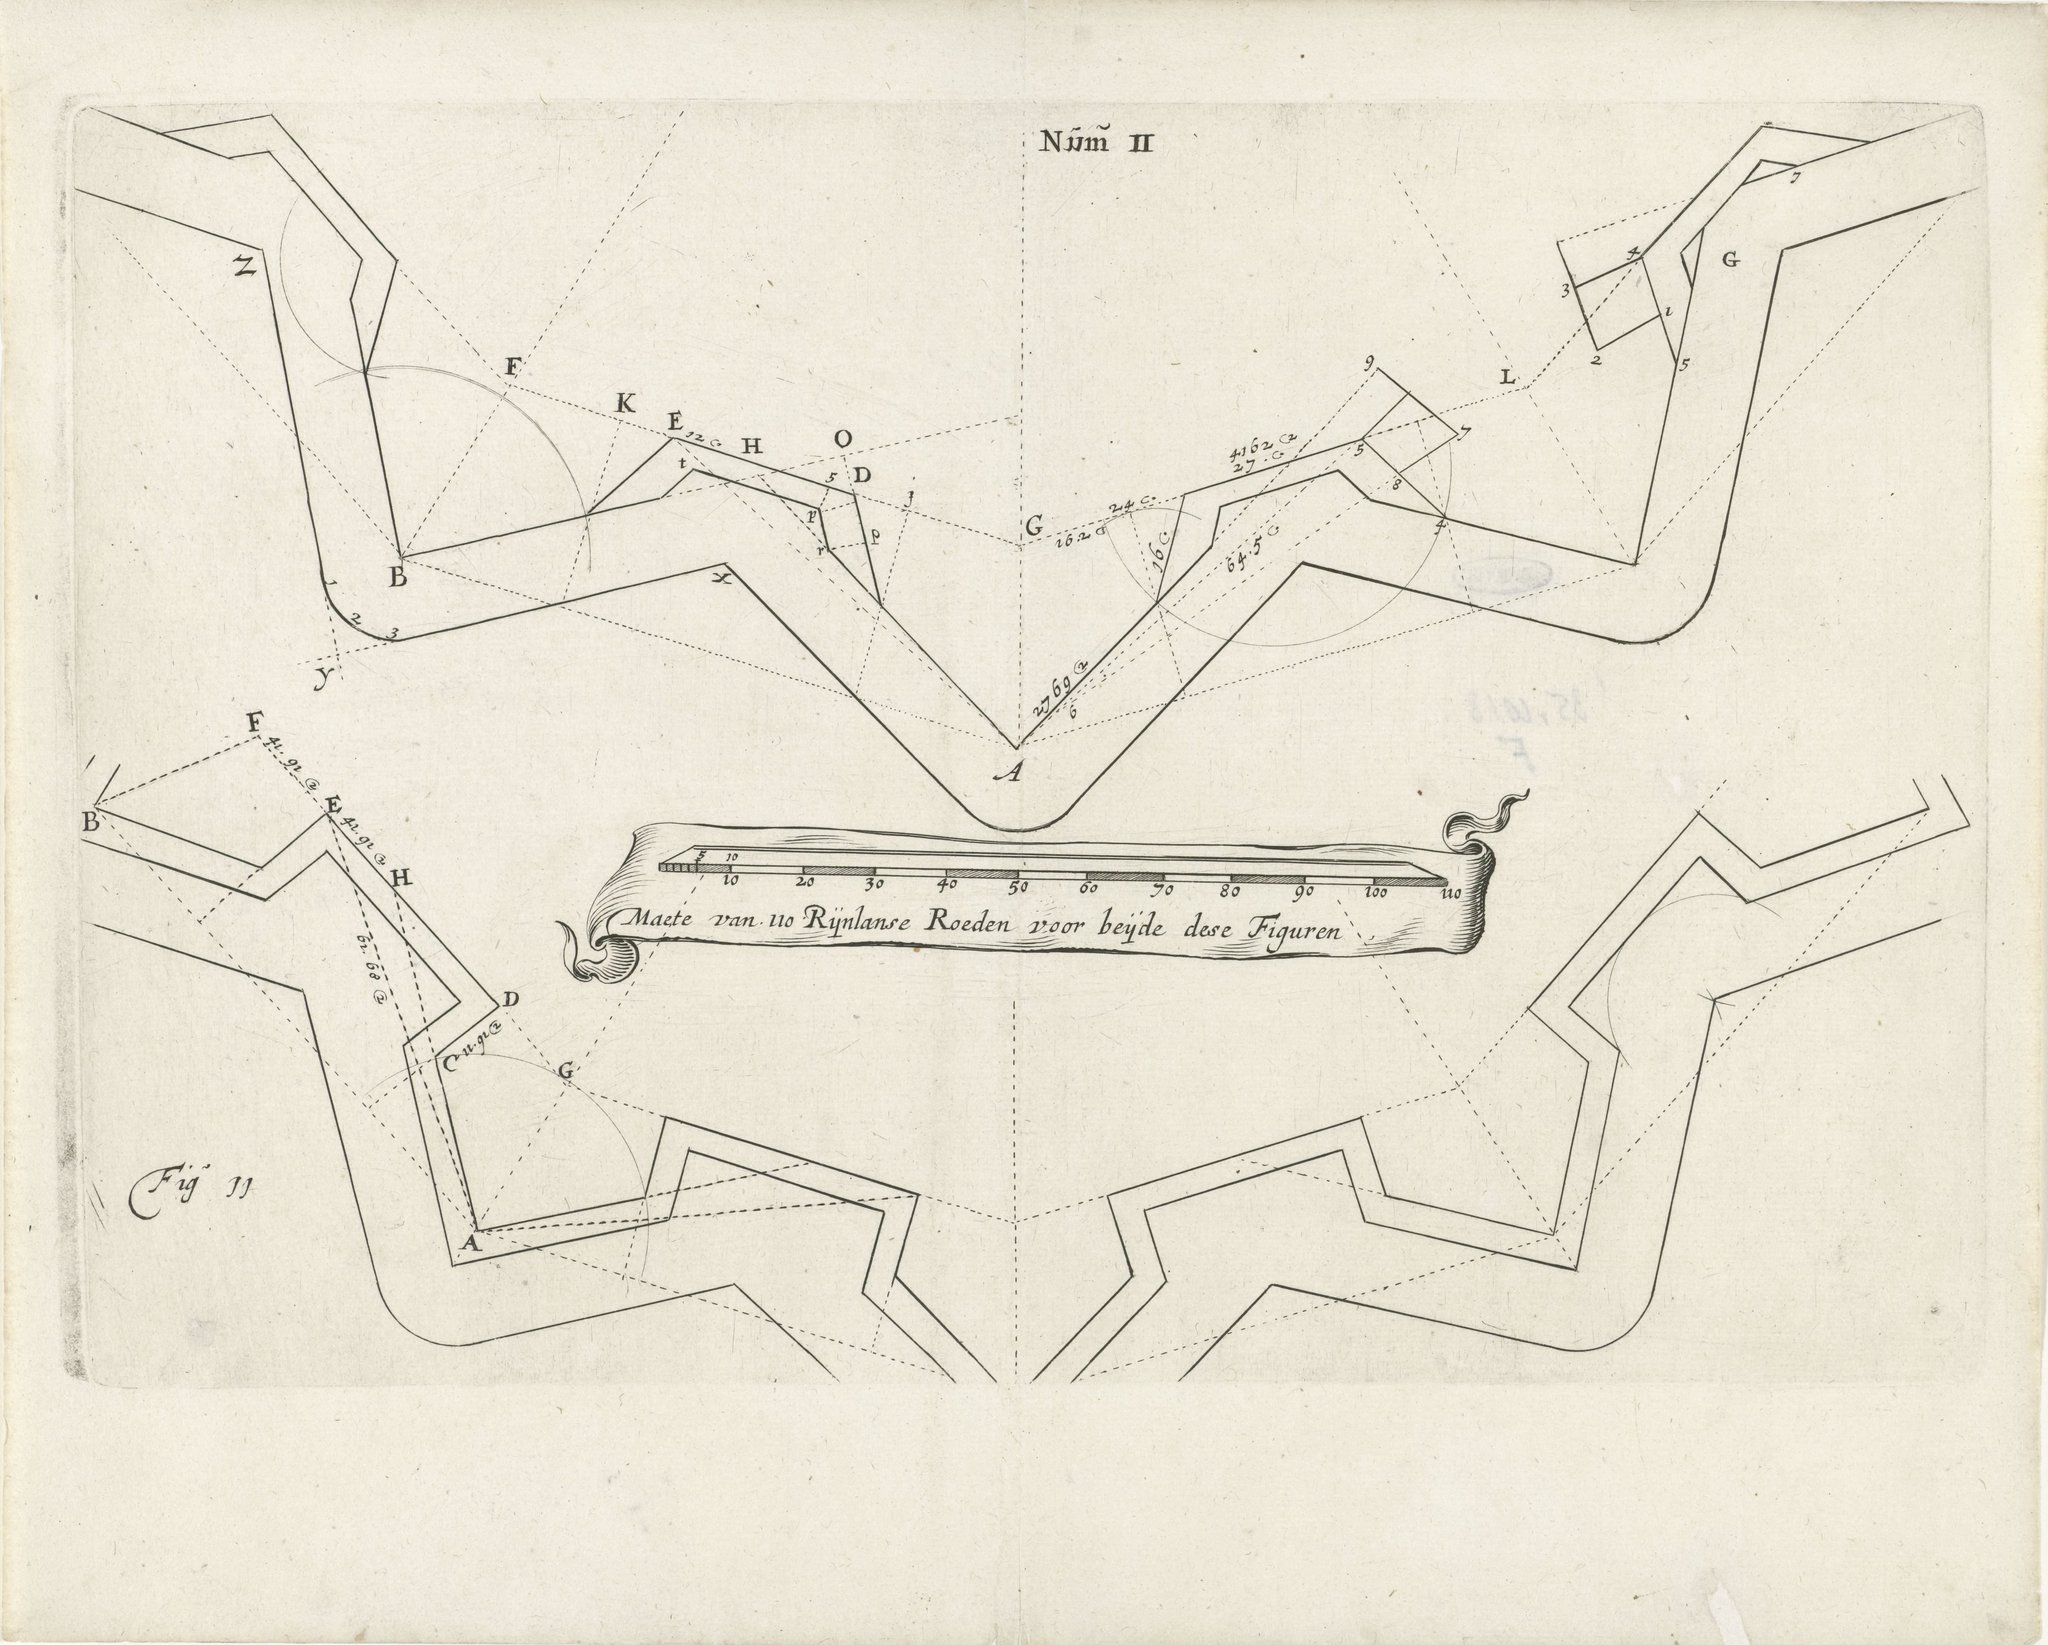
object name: print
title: Plattegrond van versterkte vestingmuur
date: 1654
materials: paper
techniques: engraving, etching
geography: amsterdam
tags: drawing (industrial process) (+ technical aspects ~ crafts, industries, agriculture), fortifications, military engineering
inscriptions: collector's mark: Lugt 2760, collector's mark: Lugt 2228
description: Illustratie voor: Henrich Ruse. Versterckte Vesting. Amsterdam: Johannes Willemszoon Blaeu, 1654.